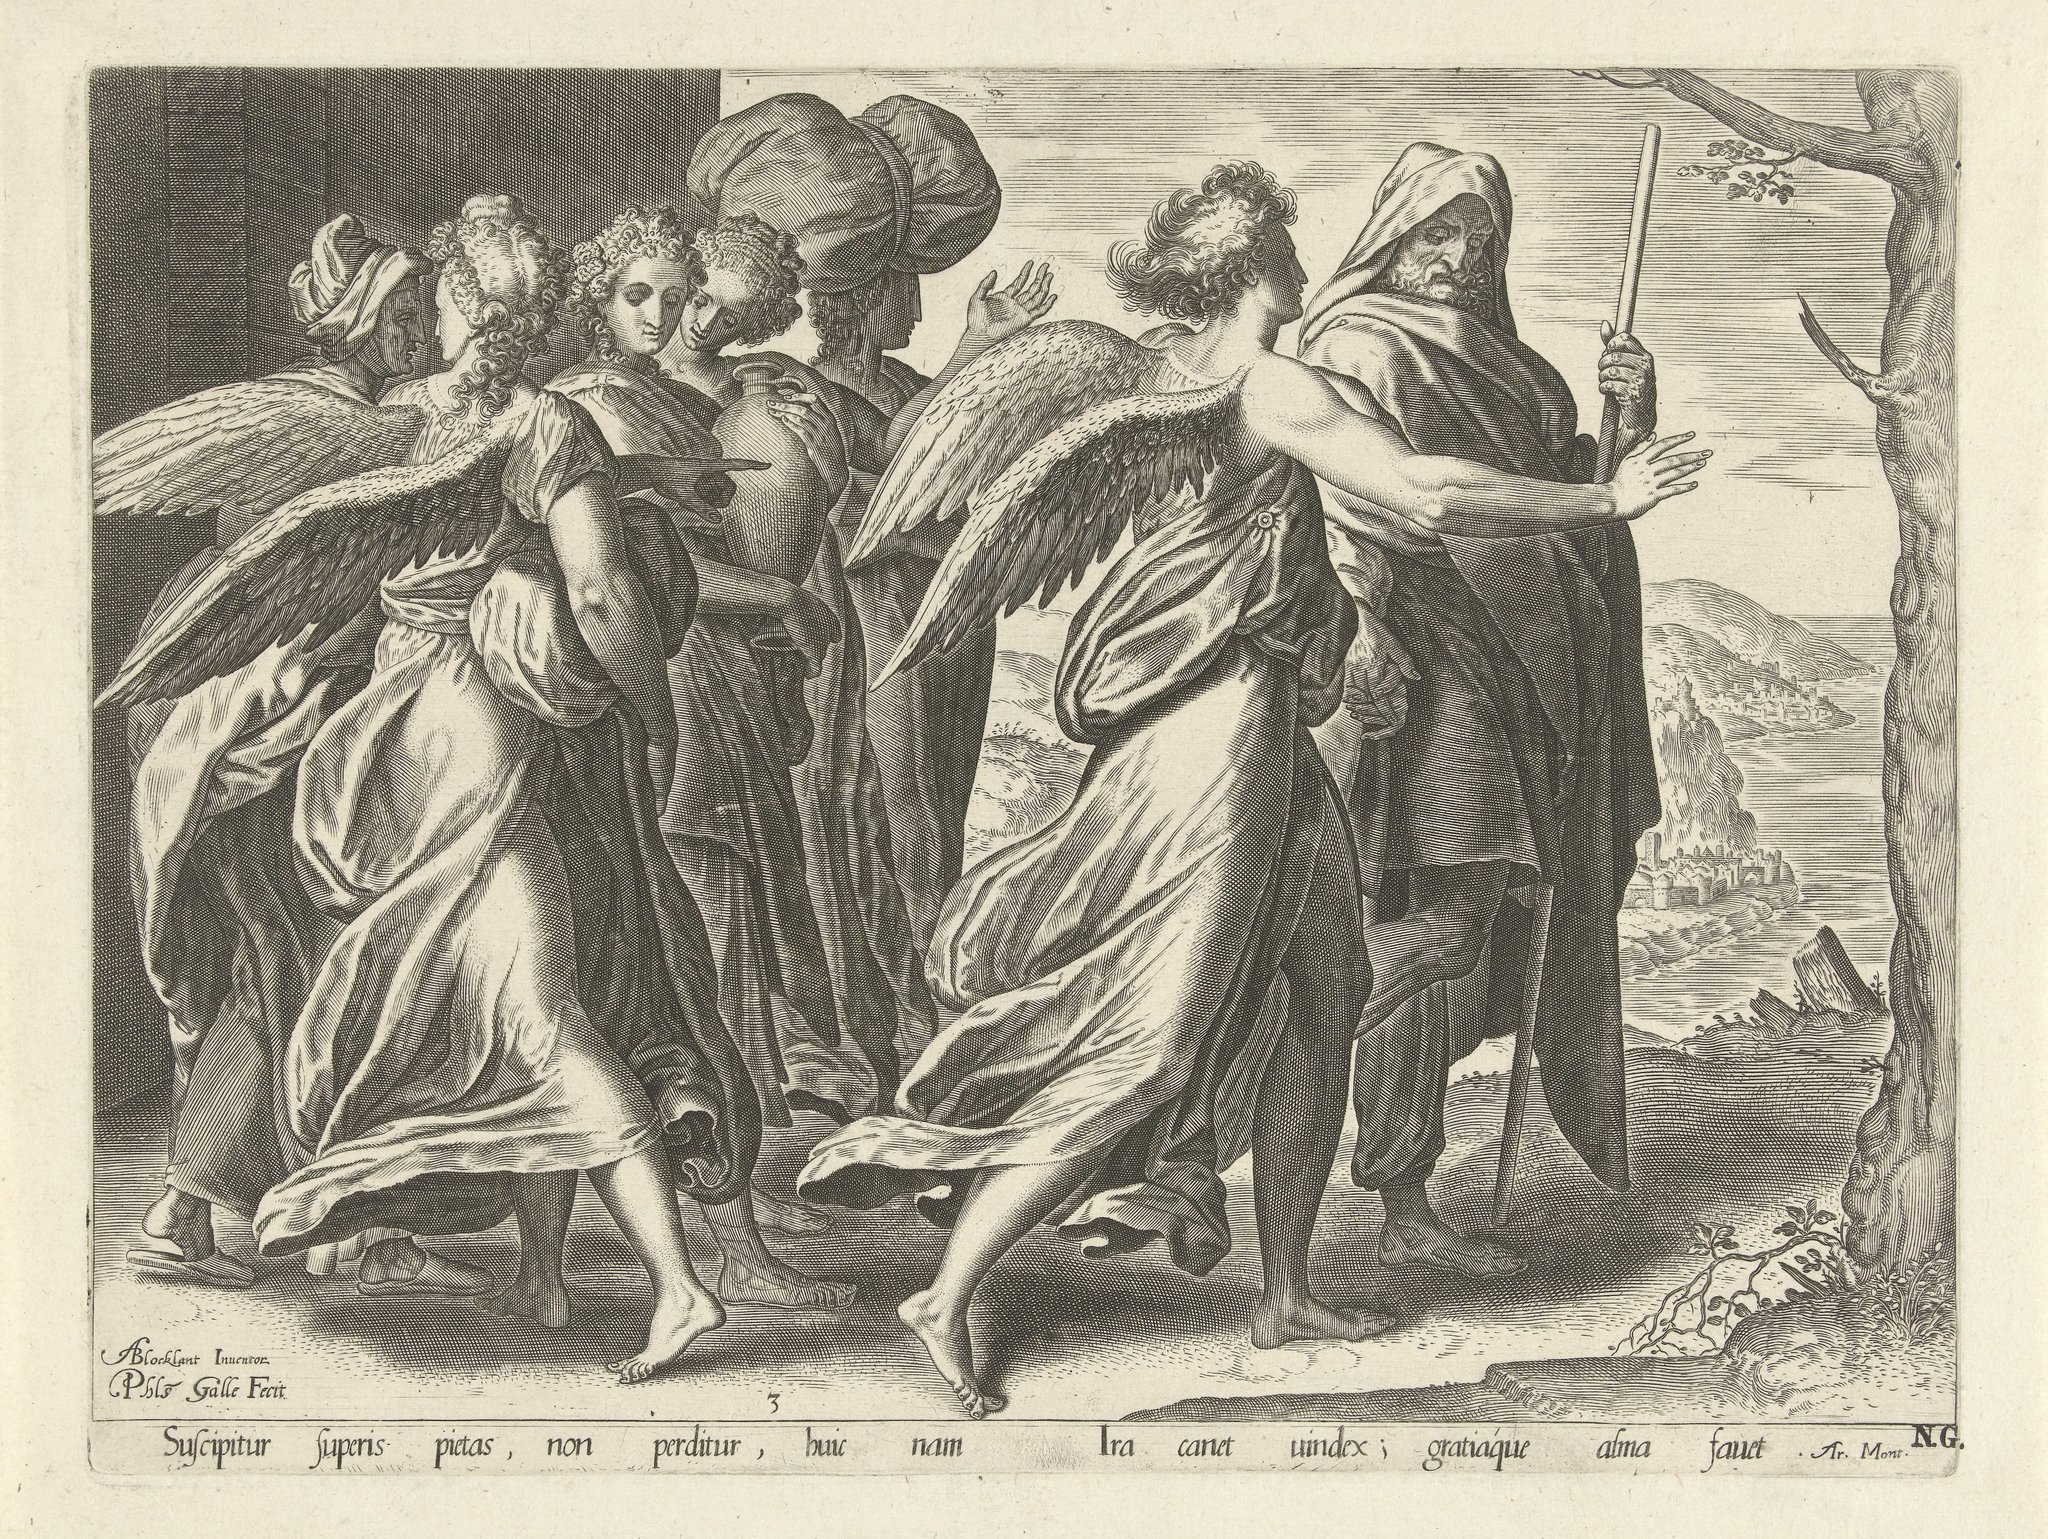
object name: print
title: Geschiedenis van Lot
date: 1557-1570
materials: paper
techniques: engraving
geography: haarlem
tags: the angels urge lot to hurry in leaving the city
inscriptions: collector's mark: Lugt 1967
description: De twee engelen begeleiden Lot en zijn familie de stad uit. Op de achtergrond een heuvelachtig landschap met een rivier.